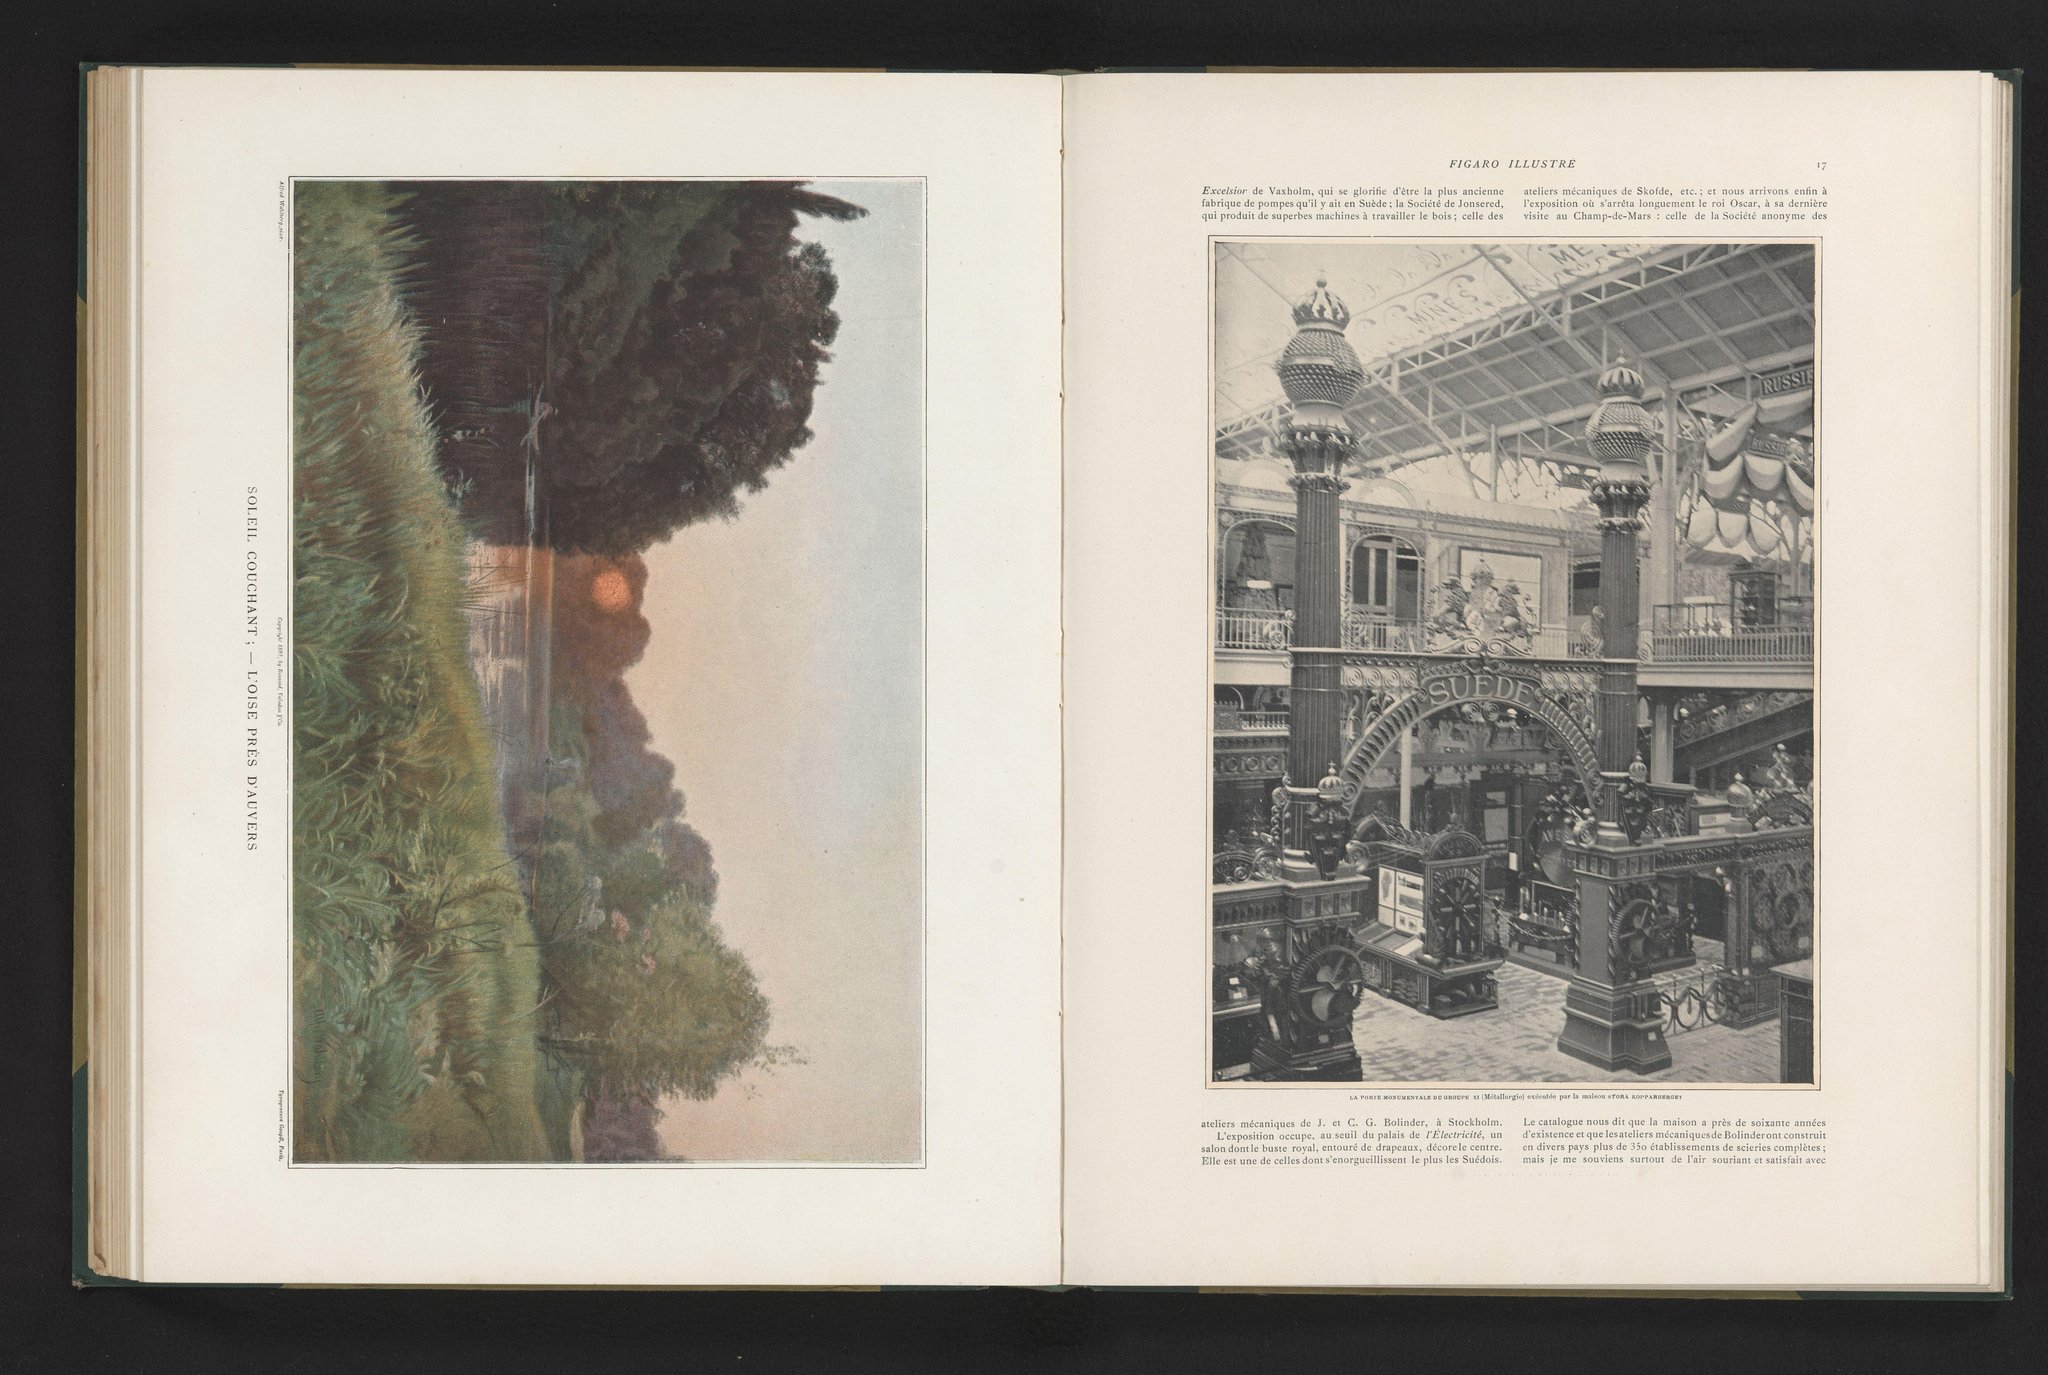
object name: photomechanical print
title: Reproductie van een schilderij van een zonsondergang over een meer nabij Auvers door Alfred Wahlberg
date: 1885-1901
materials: paper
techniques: four-color autotype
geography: paris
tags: lake, sunset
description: Prent tegenover pagina 17 van Figaro-Illustré (Juillet 1900).